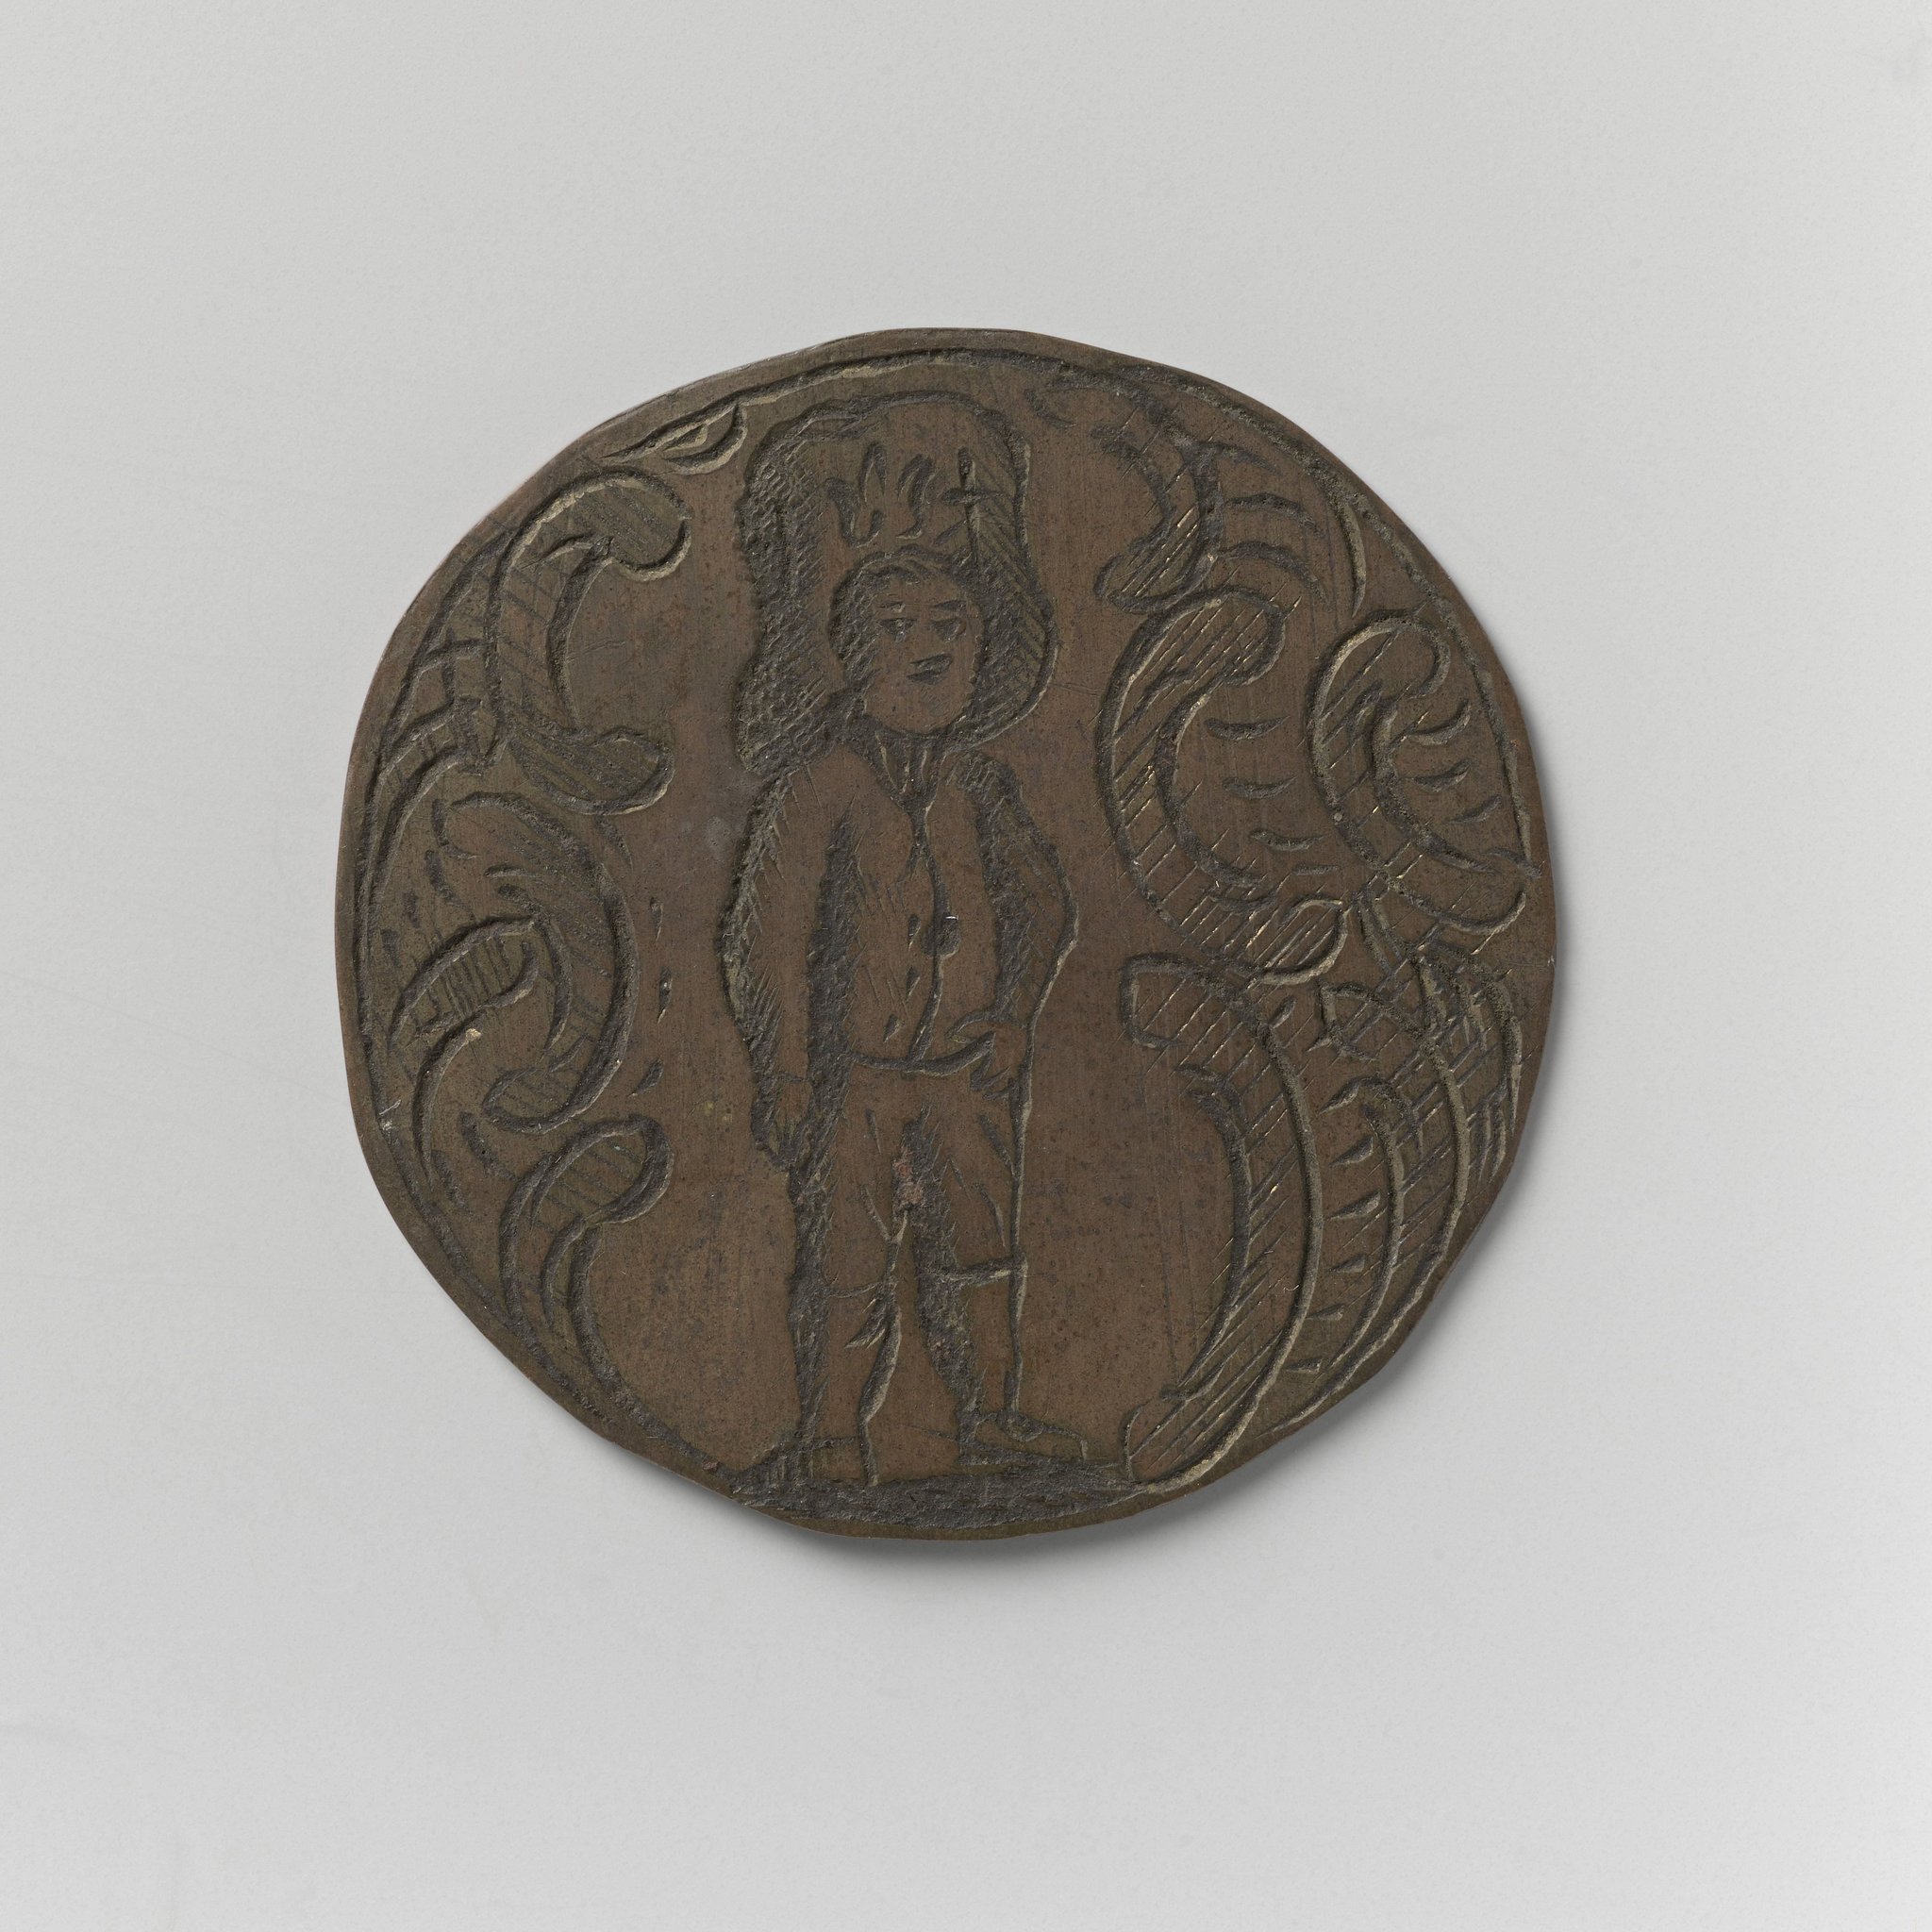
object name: medal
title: Korendragers- en -stortersgilde van Amsterdam, gildepenning van Hendrik Egelink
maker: Anonymous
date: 1793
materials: copper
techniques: engraving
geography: amsterdam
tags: amsterdam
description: Koperen penning. Voorzijde: lichtelijk naar rechts gewende man met last op hoofd binnen sierrand. Keerzijde: opschrift